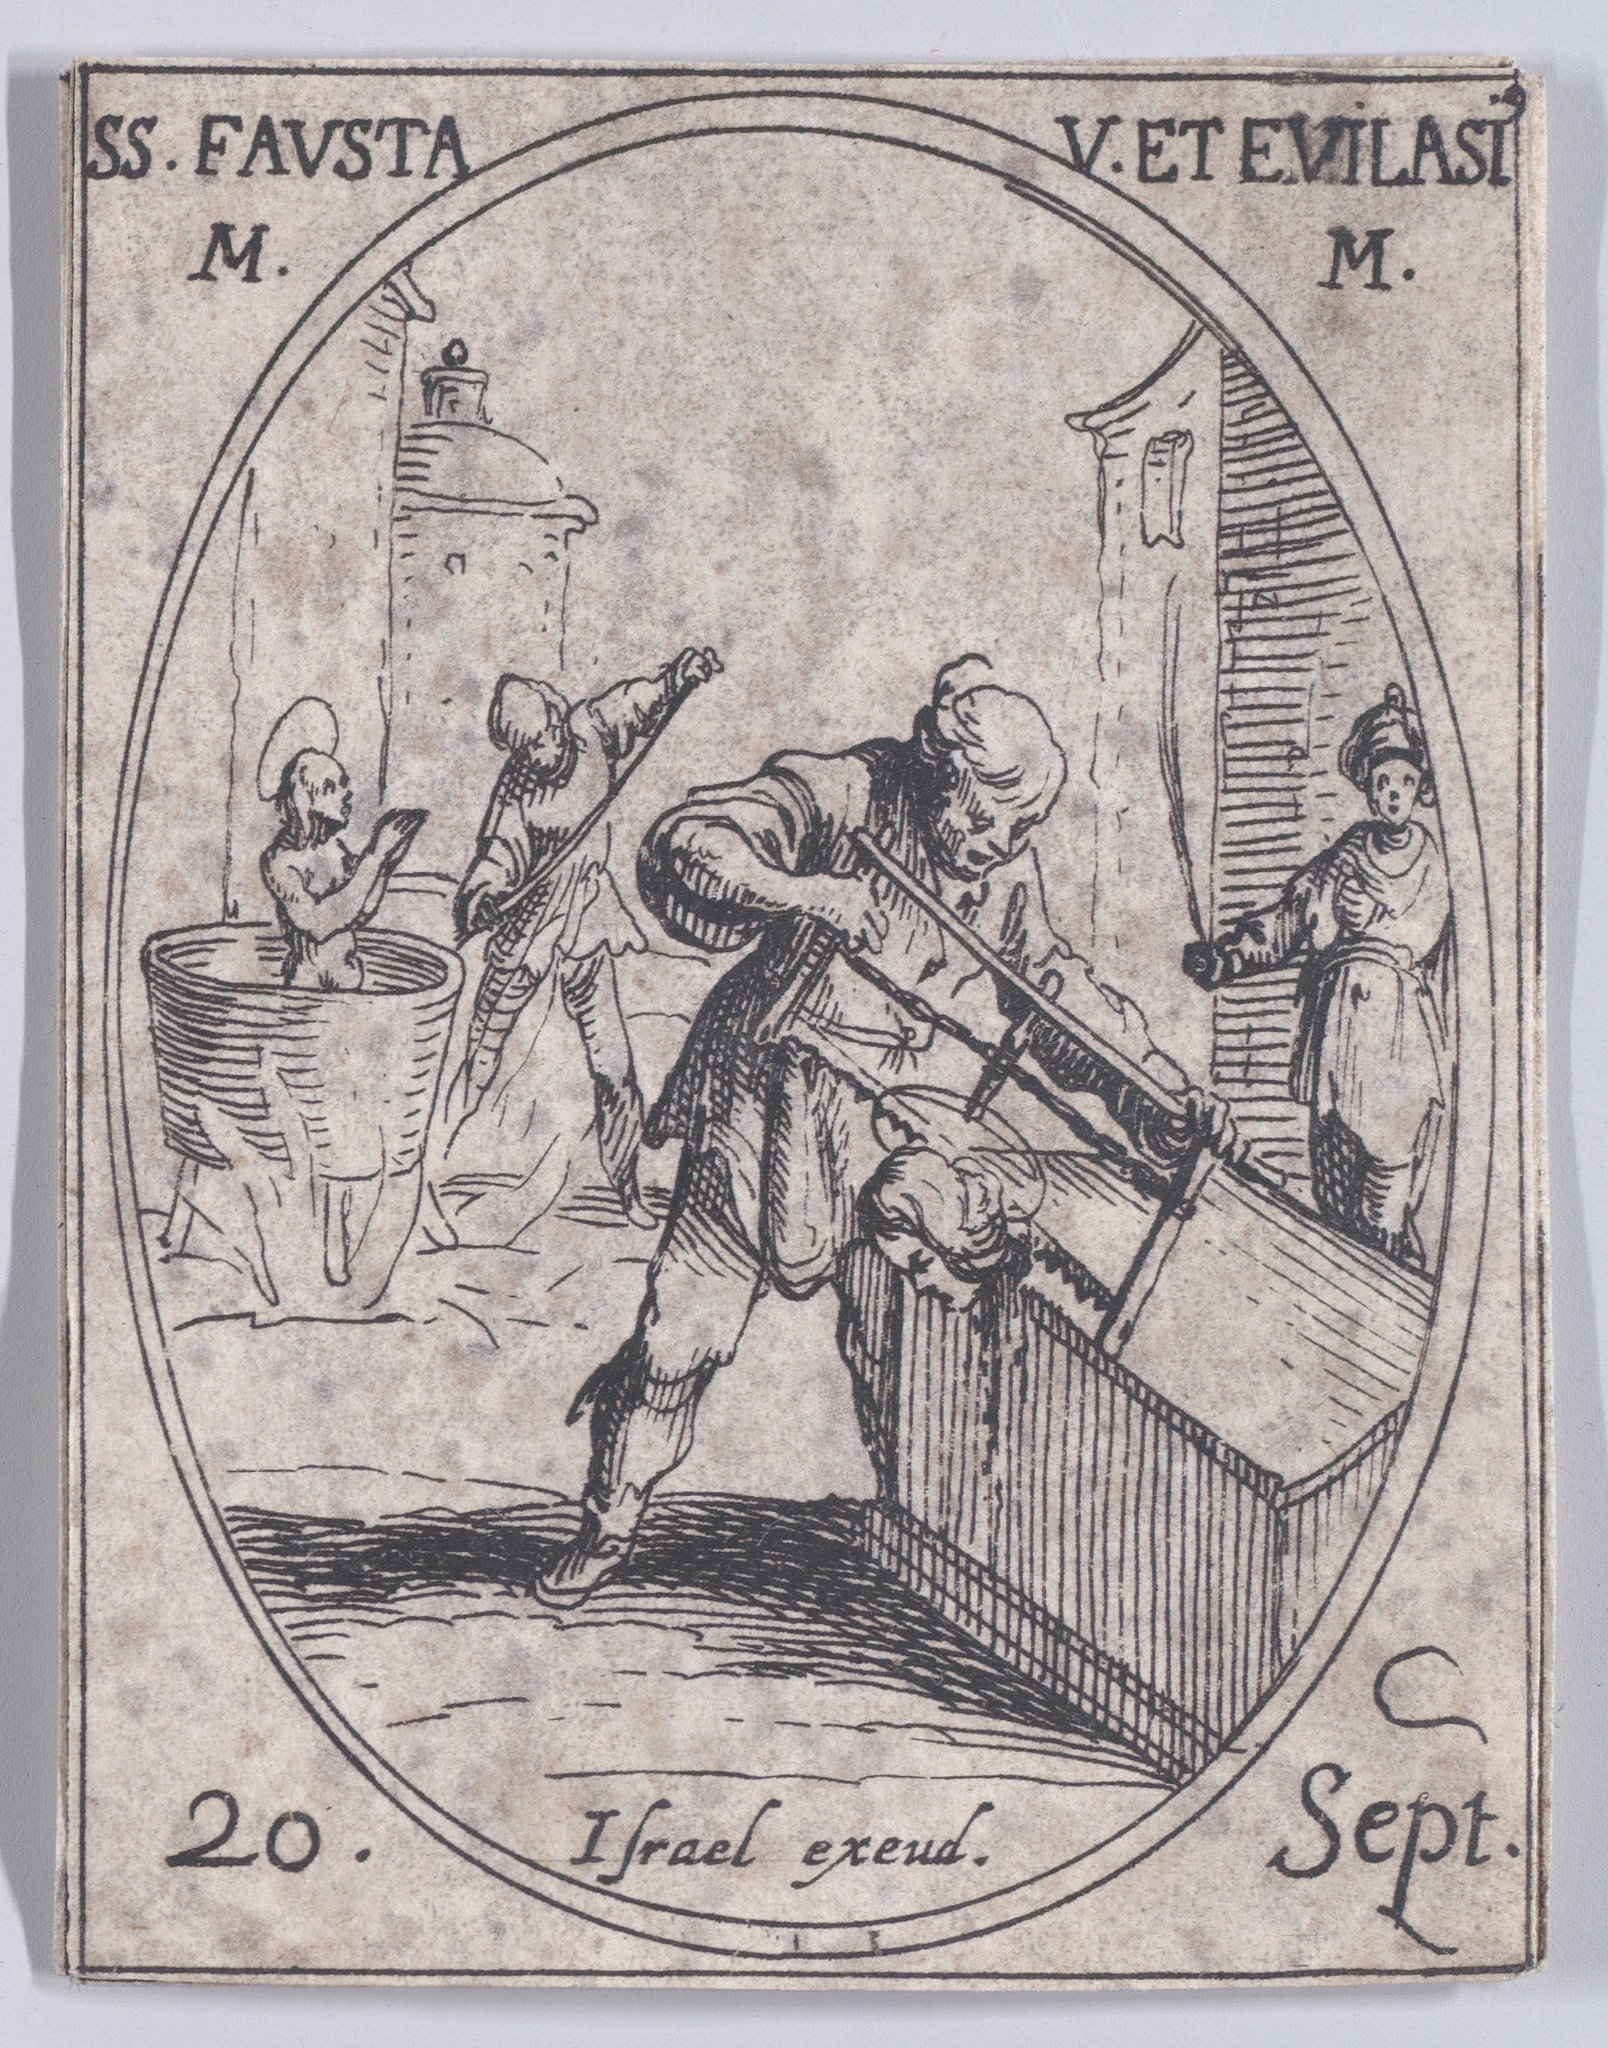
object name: print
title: Ste. Fauste et S. Evilase (St. Fausta and St. Evilasius), September 20th, from "Les Images De Tous Les Saincts et Saintes de L'Année" (Images of All of the Saints and Religious Events of the Year)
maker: jacques callot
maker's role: artist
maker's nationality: french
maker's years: 1592-1635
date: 1636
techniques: etching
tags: men,saints